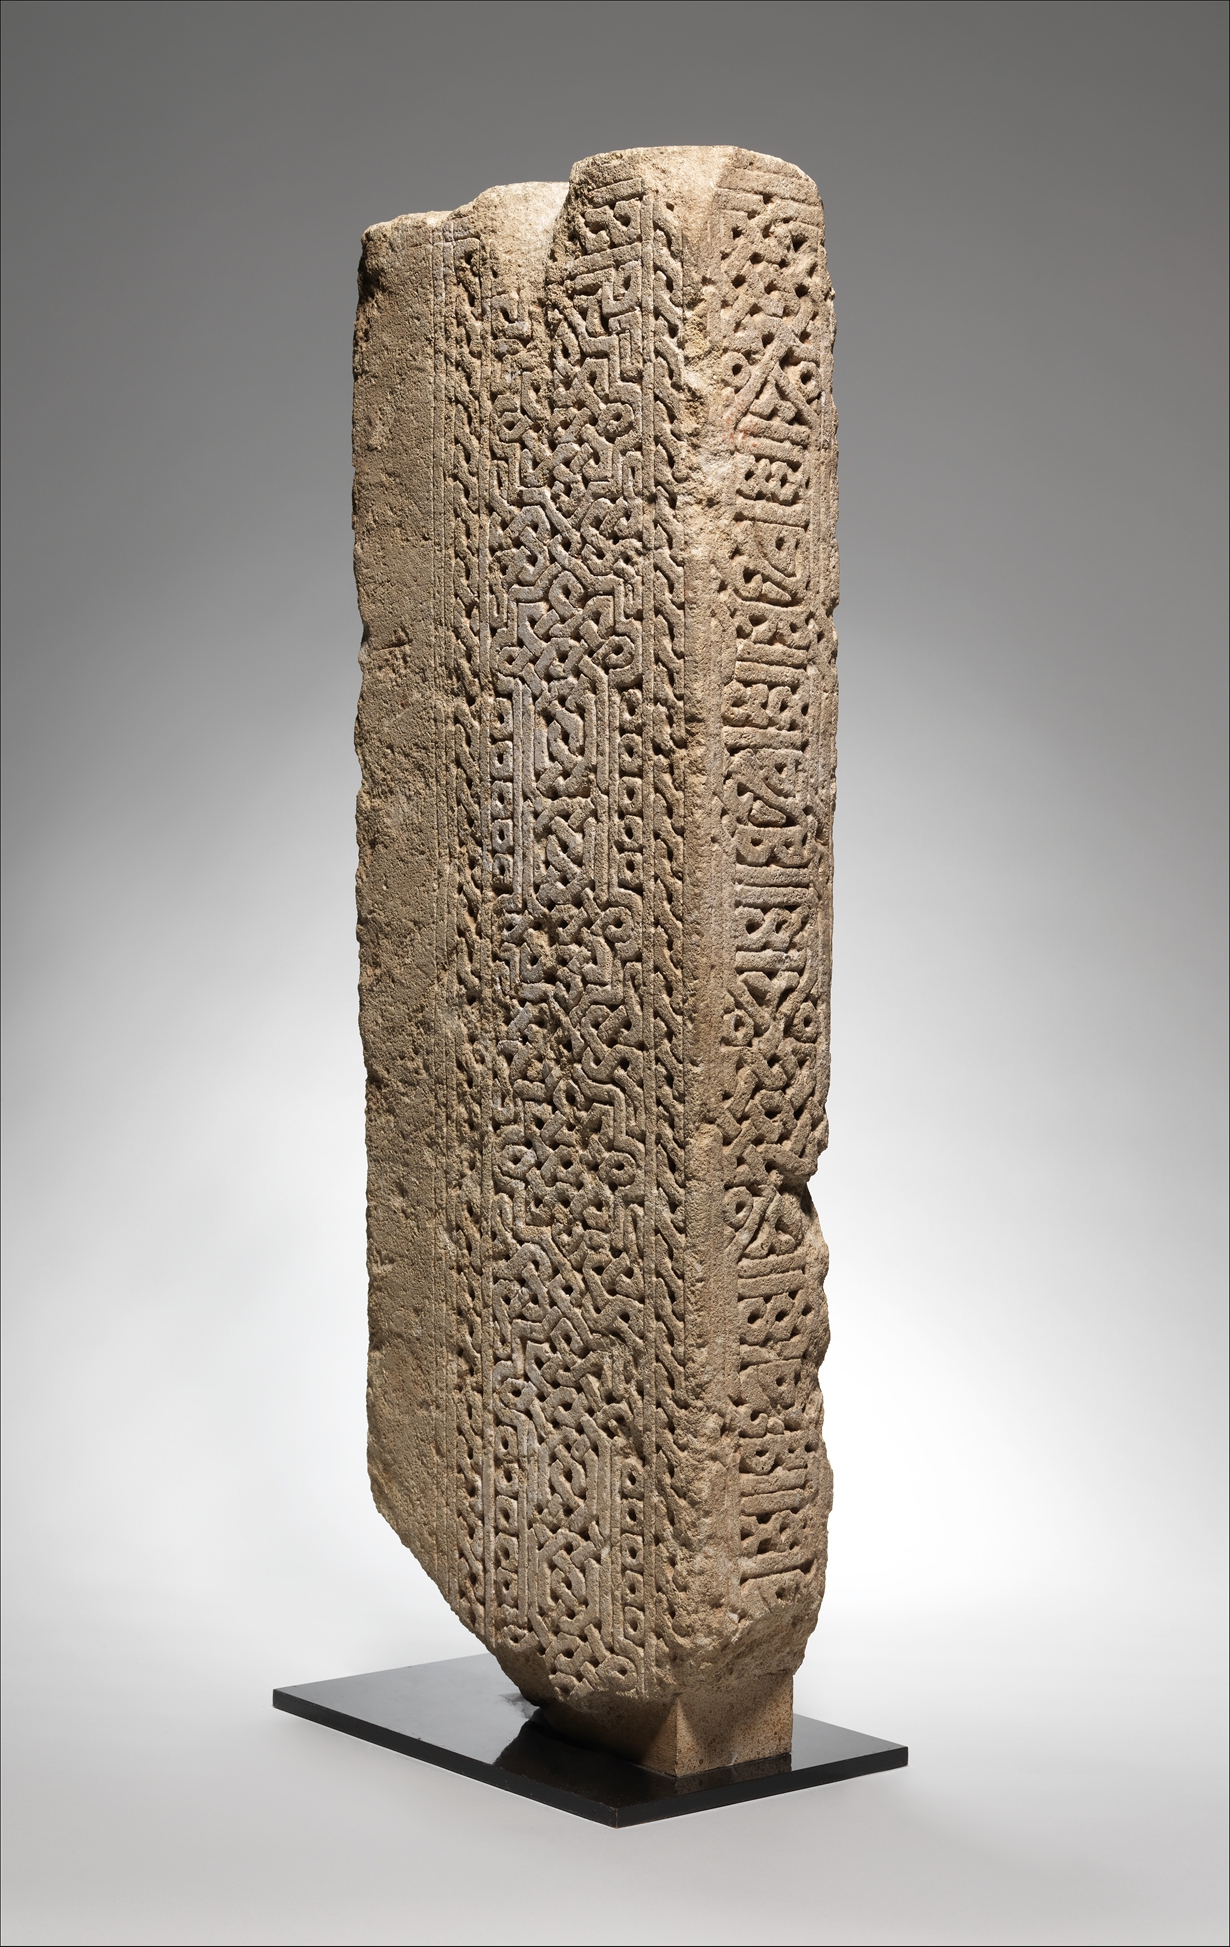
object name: panel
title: Panel with Geometric Pattern and Benedictory Inscriptions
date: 1267-1366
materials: limestone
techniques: carving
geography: spain